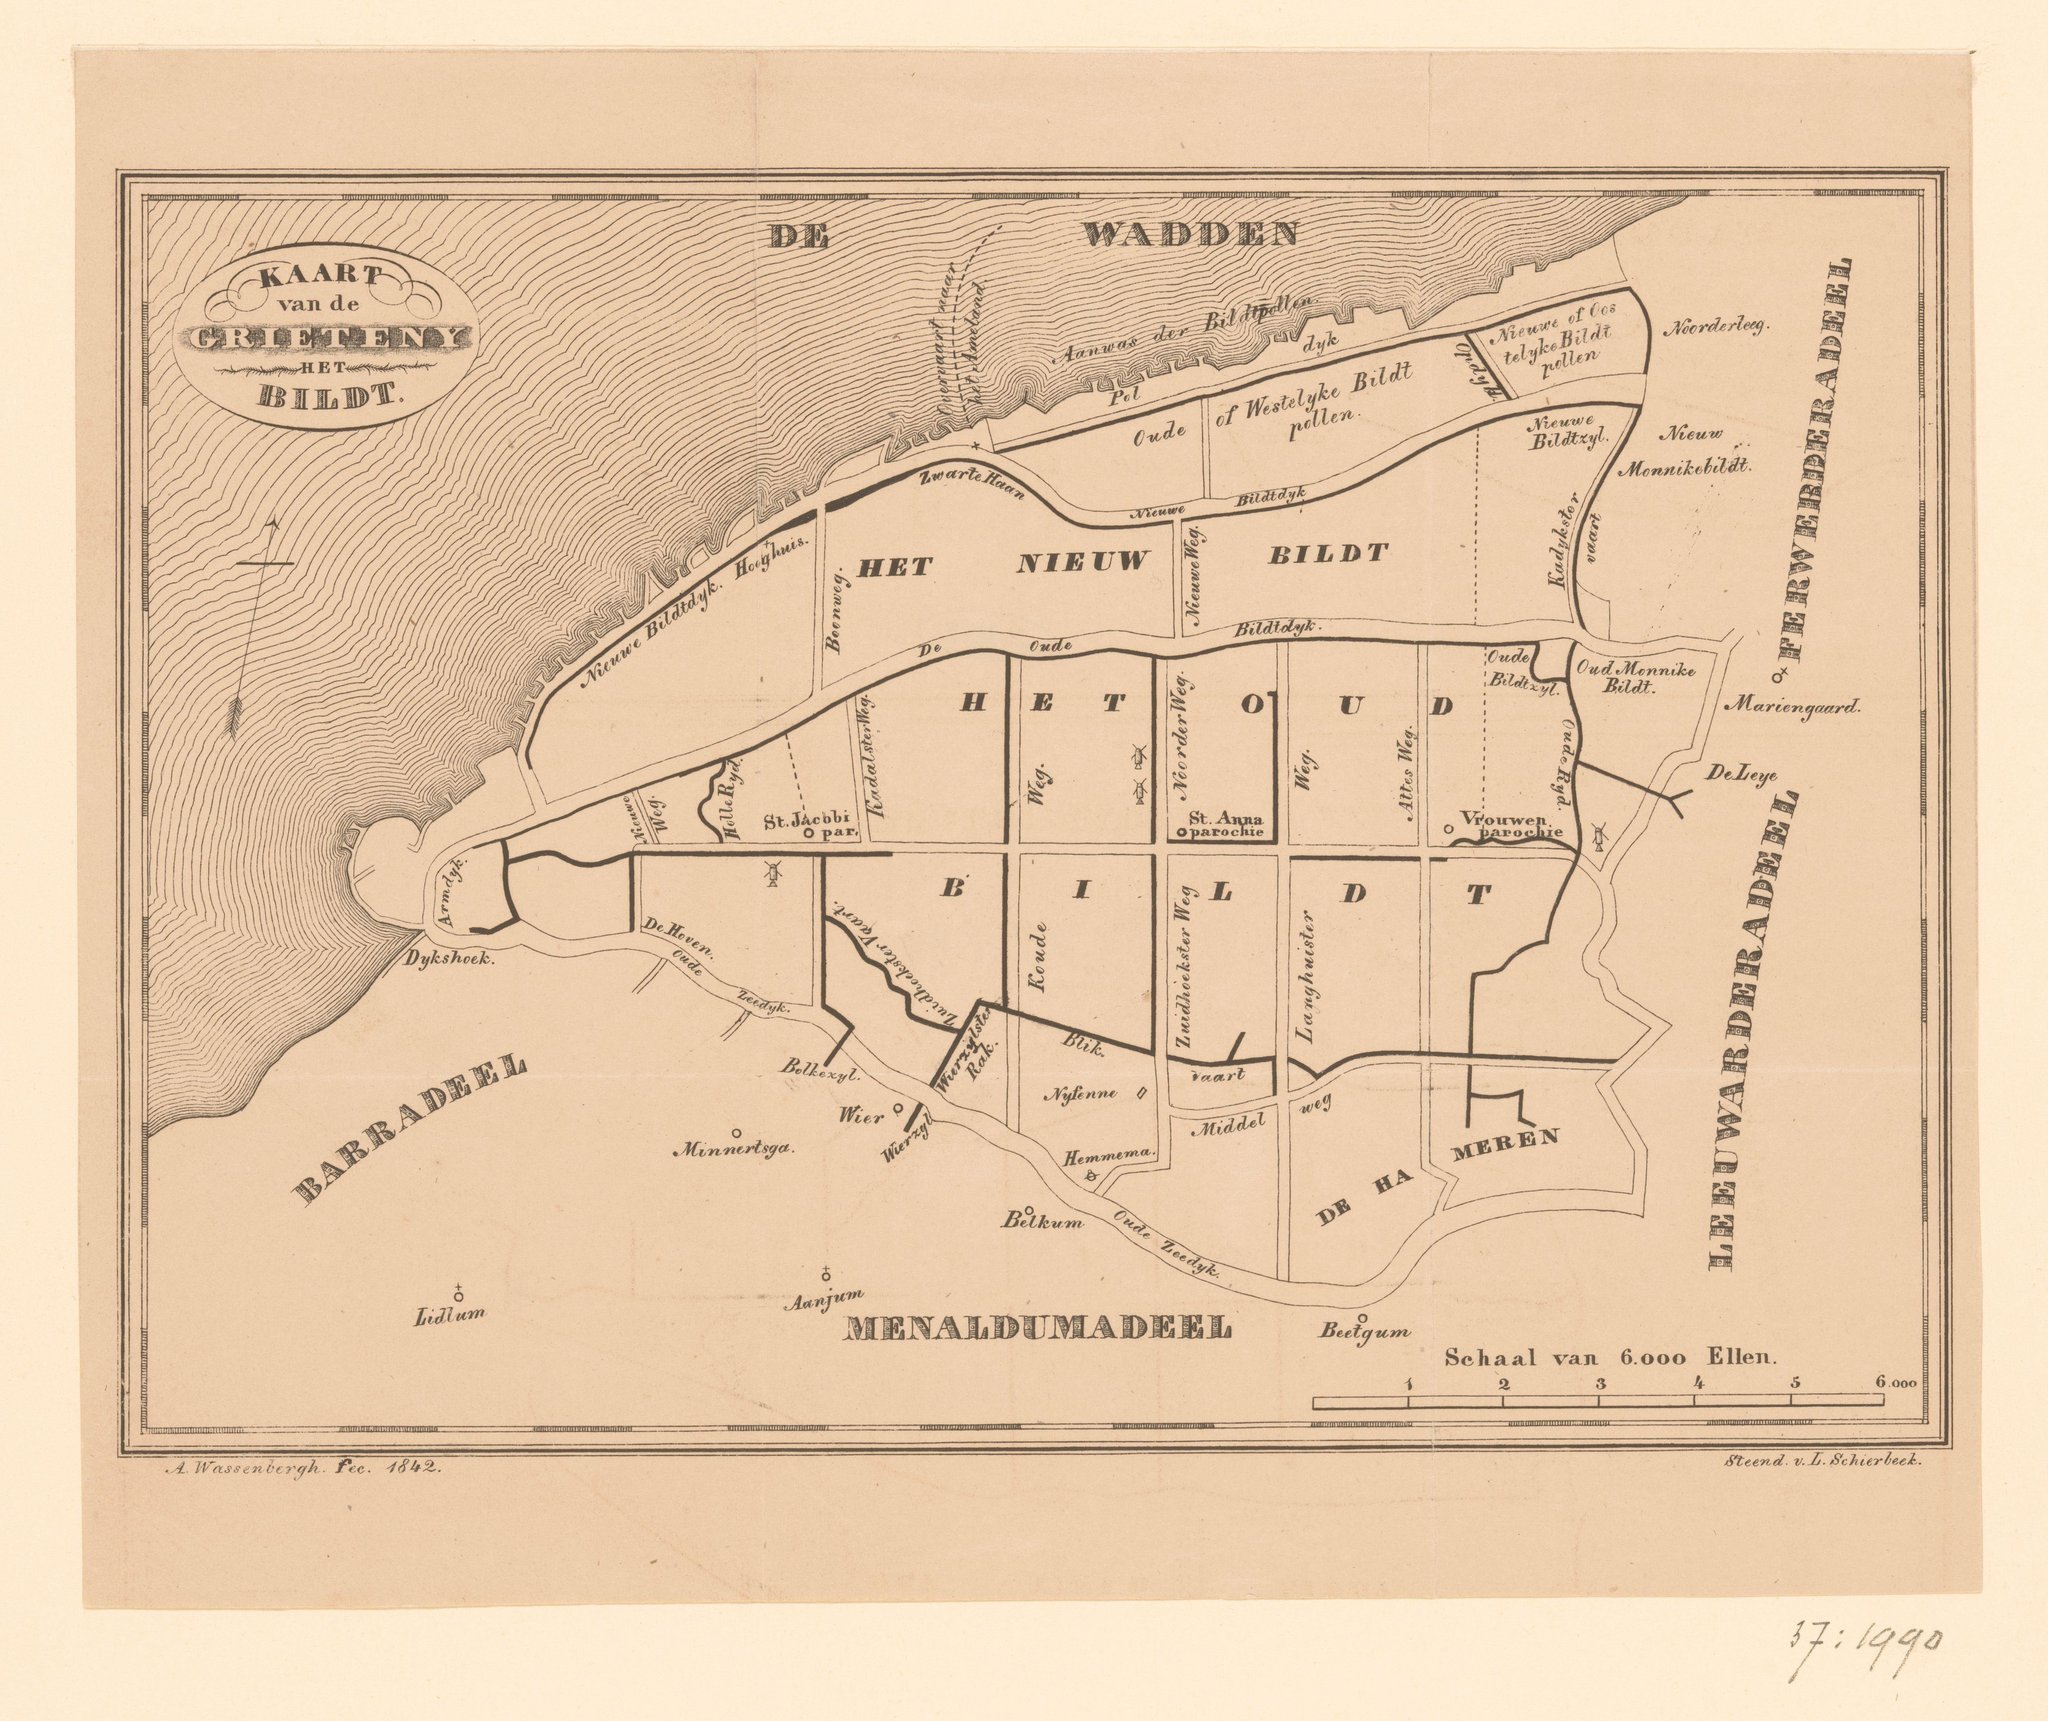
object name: print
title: Kaart van de Grieteny het Bildt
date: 1843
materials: paper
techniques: lithograph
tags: maps, atlases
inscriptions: collector's mark: Lugt 2228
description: Prent uit: Friesche Volksalmanak. 10 dln. Leeuwarden: L. Schierbeek, 1843, dl. 8.